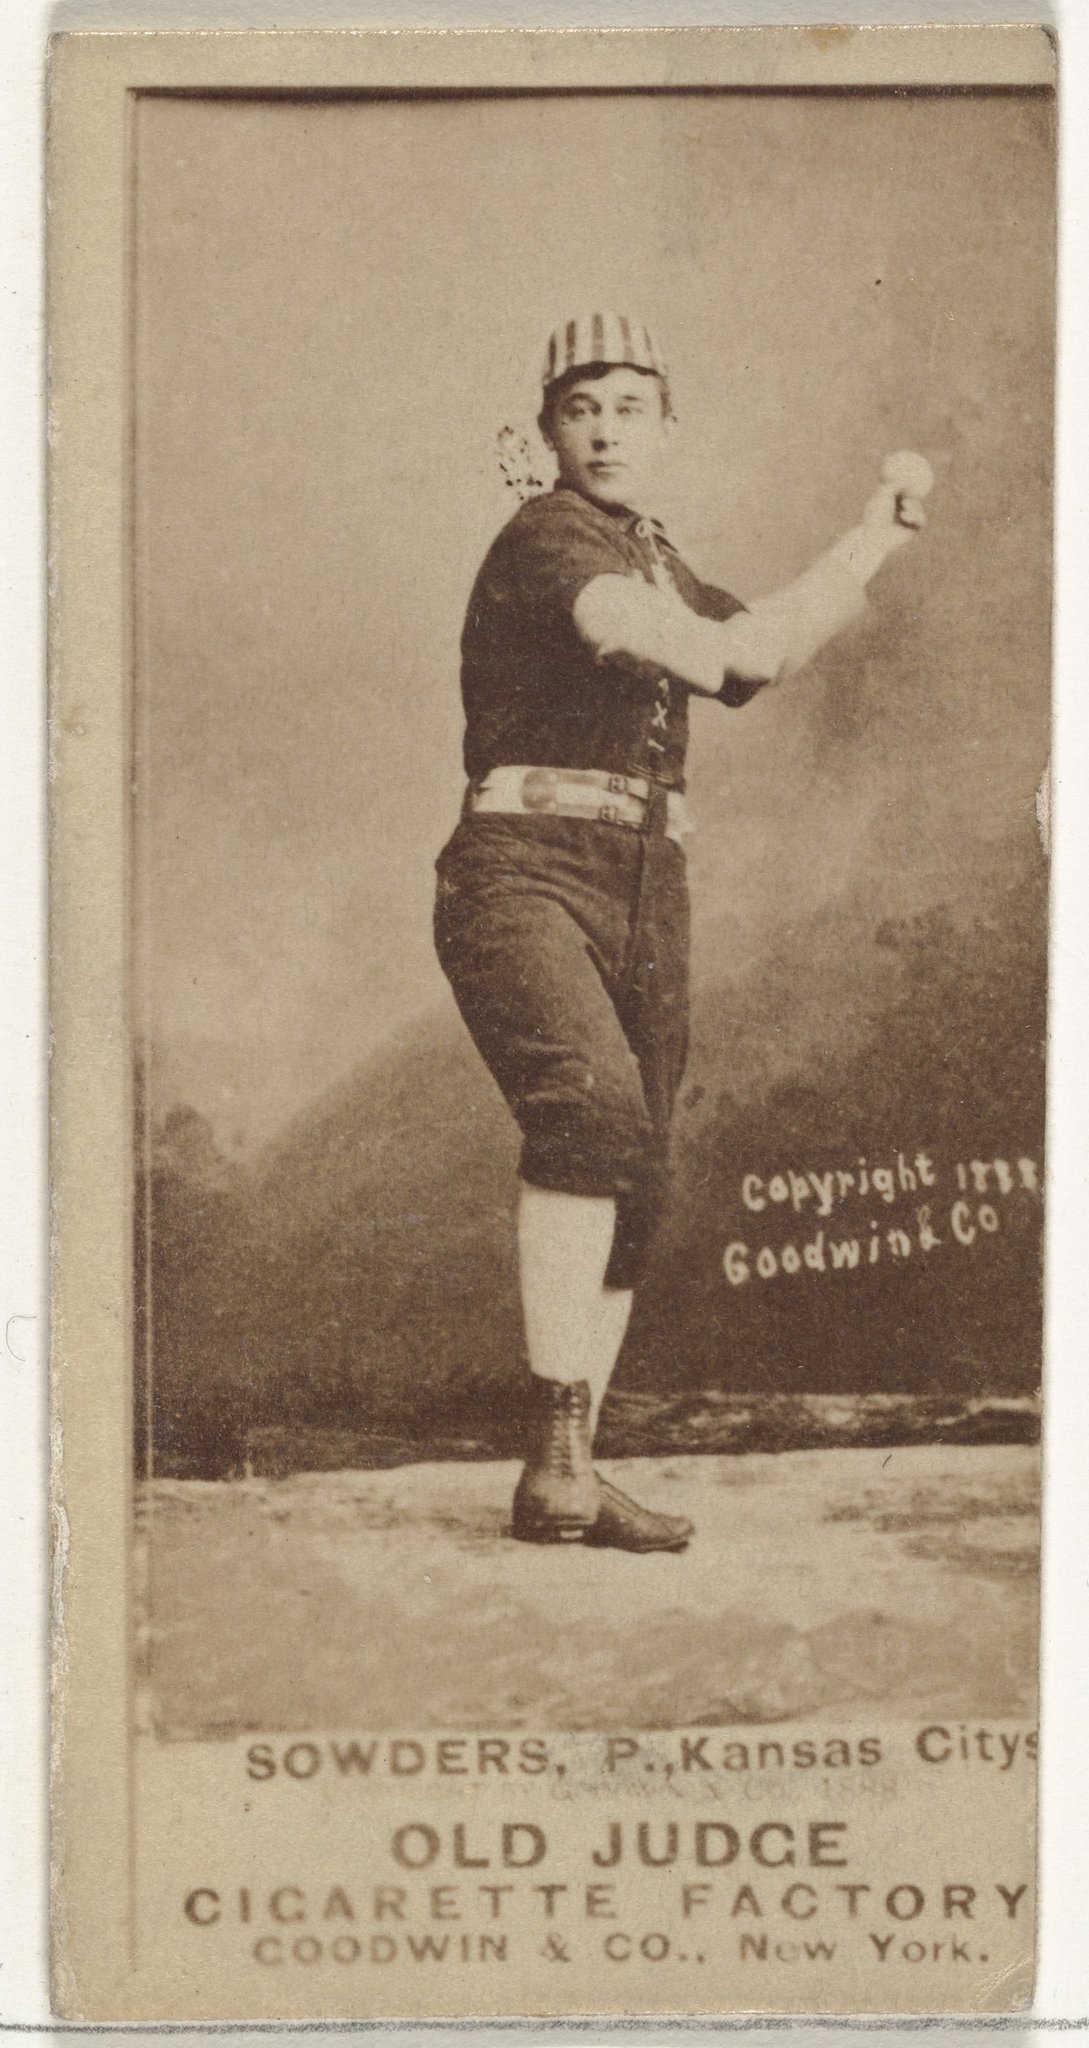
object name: baseball card, photograph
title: John Sowders, Pitcher, Kansas City Cowboys, from the Old Judge series (N172) for Old Judge Cigarettes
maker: goodwin & company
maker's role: publisher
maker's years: 1850-1950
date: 1888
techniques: albumen silver print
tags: men,portraits,baseball,athletes